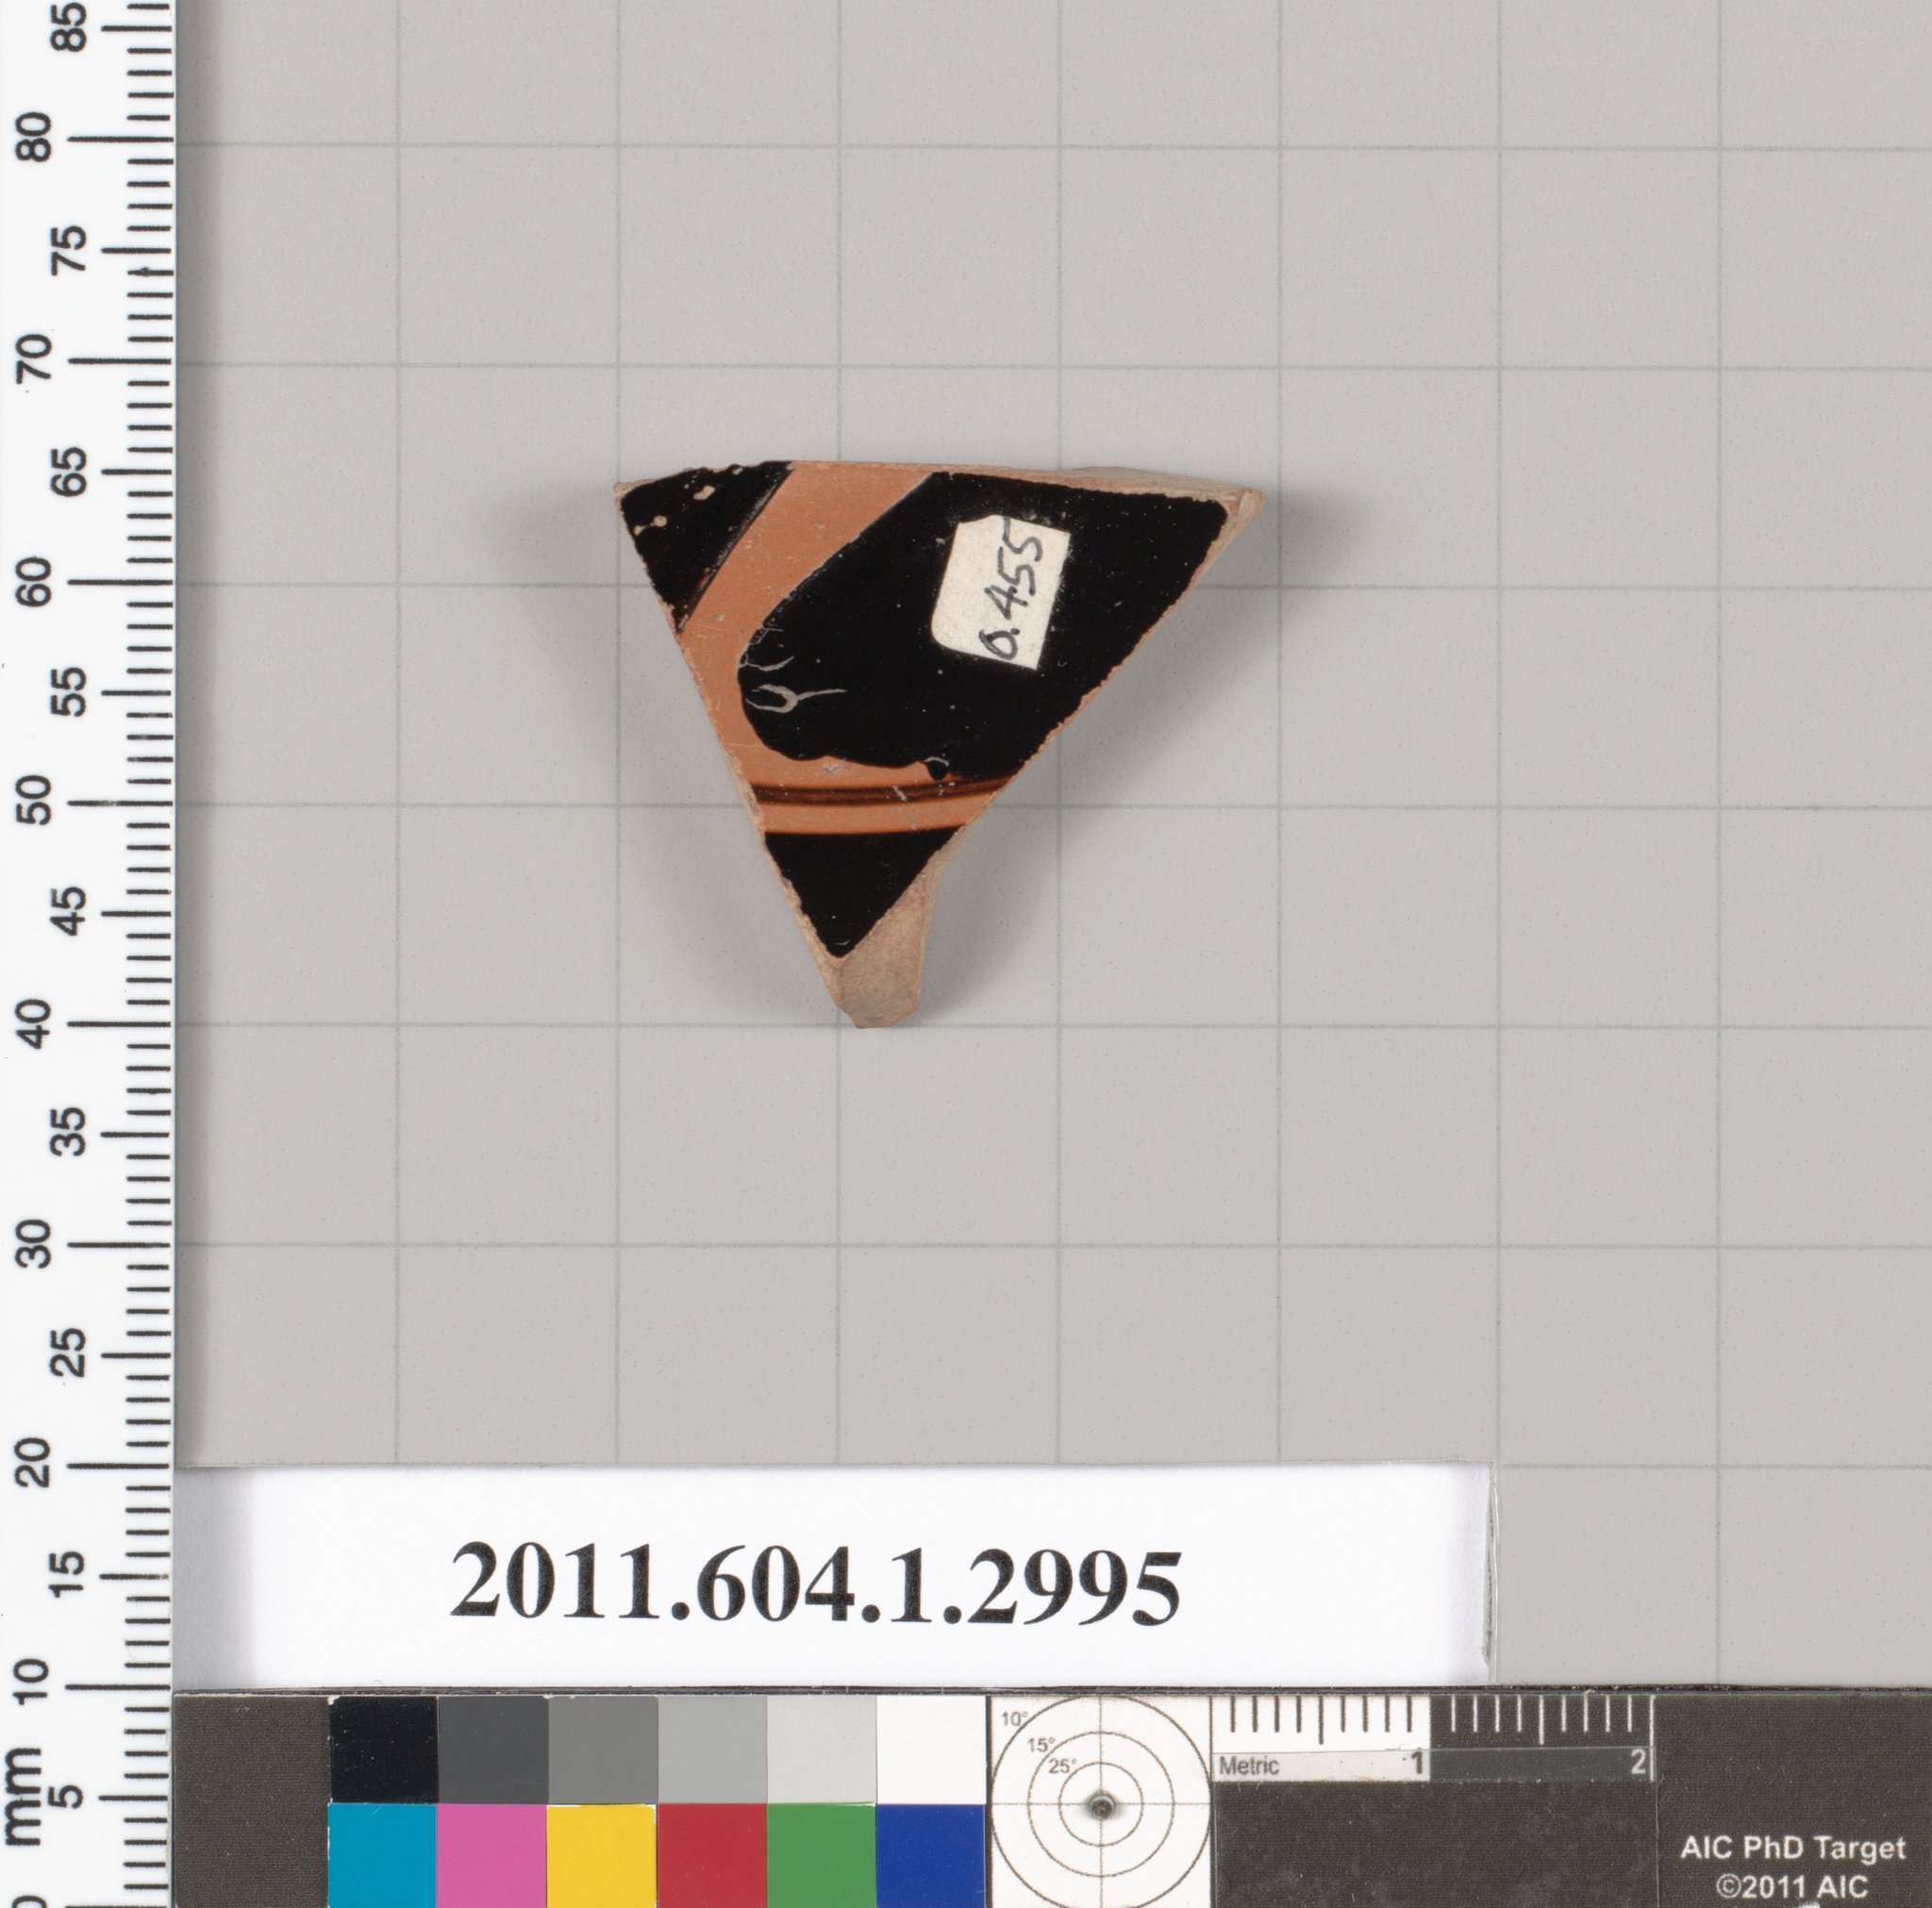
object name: kylix fragment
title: Terracotta fragment of a kylix (drinking cup)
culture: greek, attic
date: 520-500 BCE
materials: terracotta